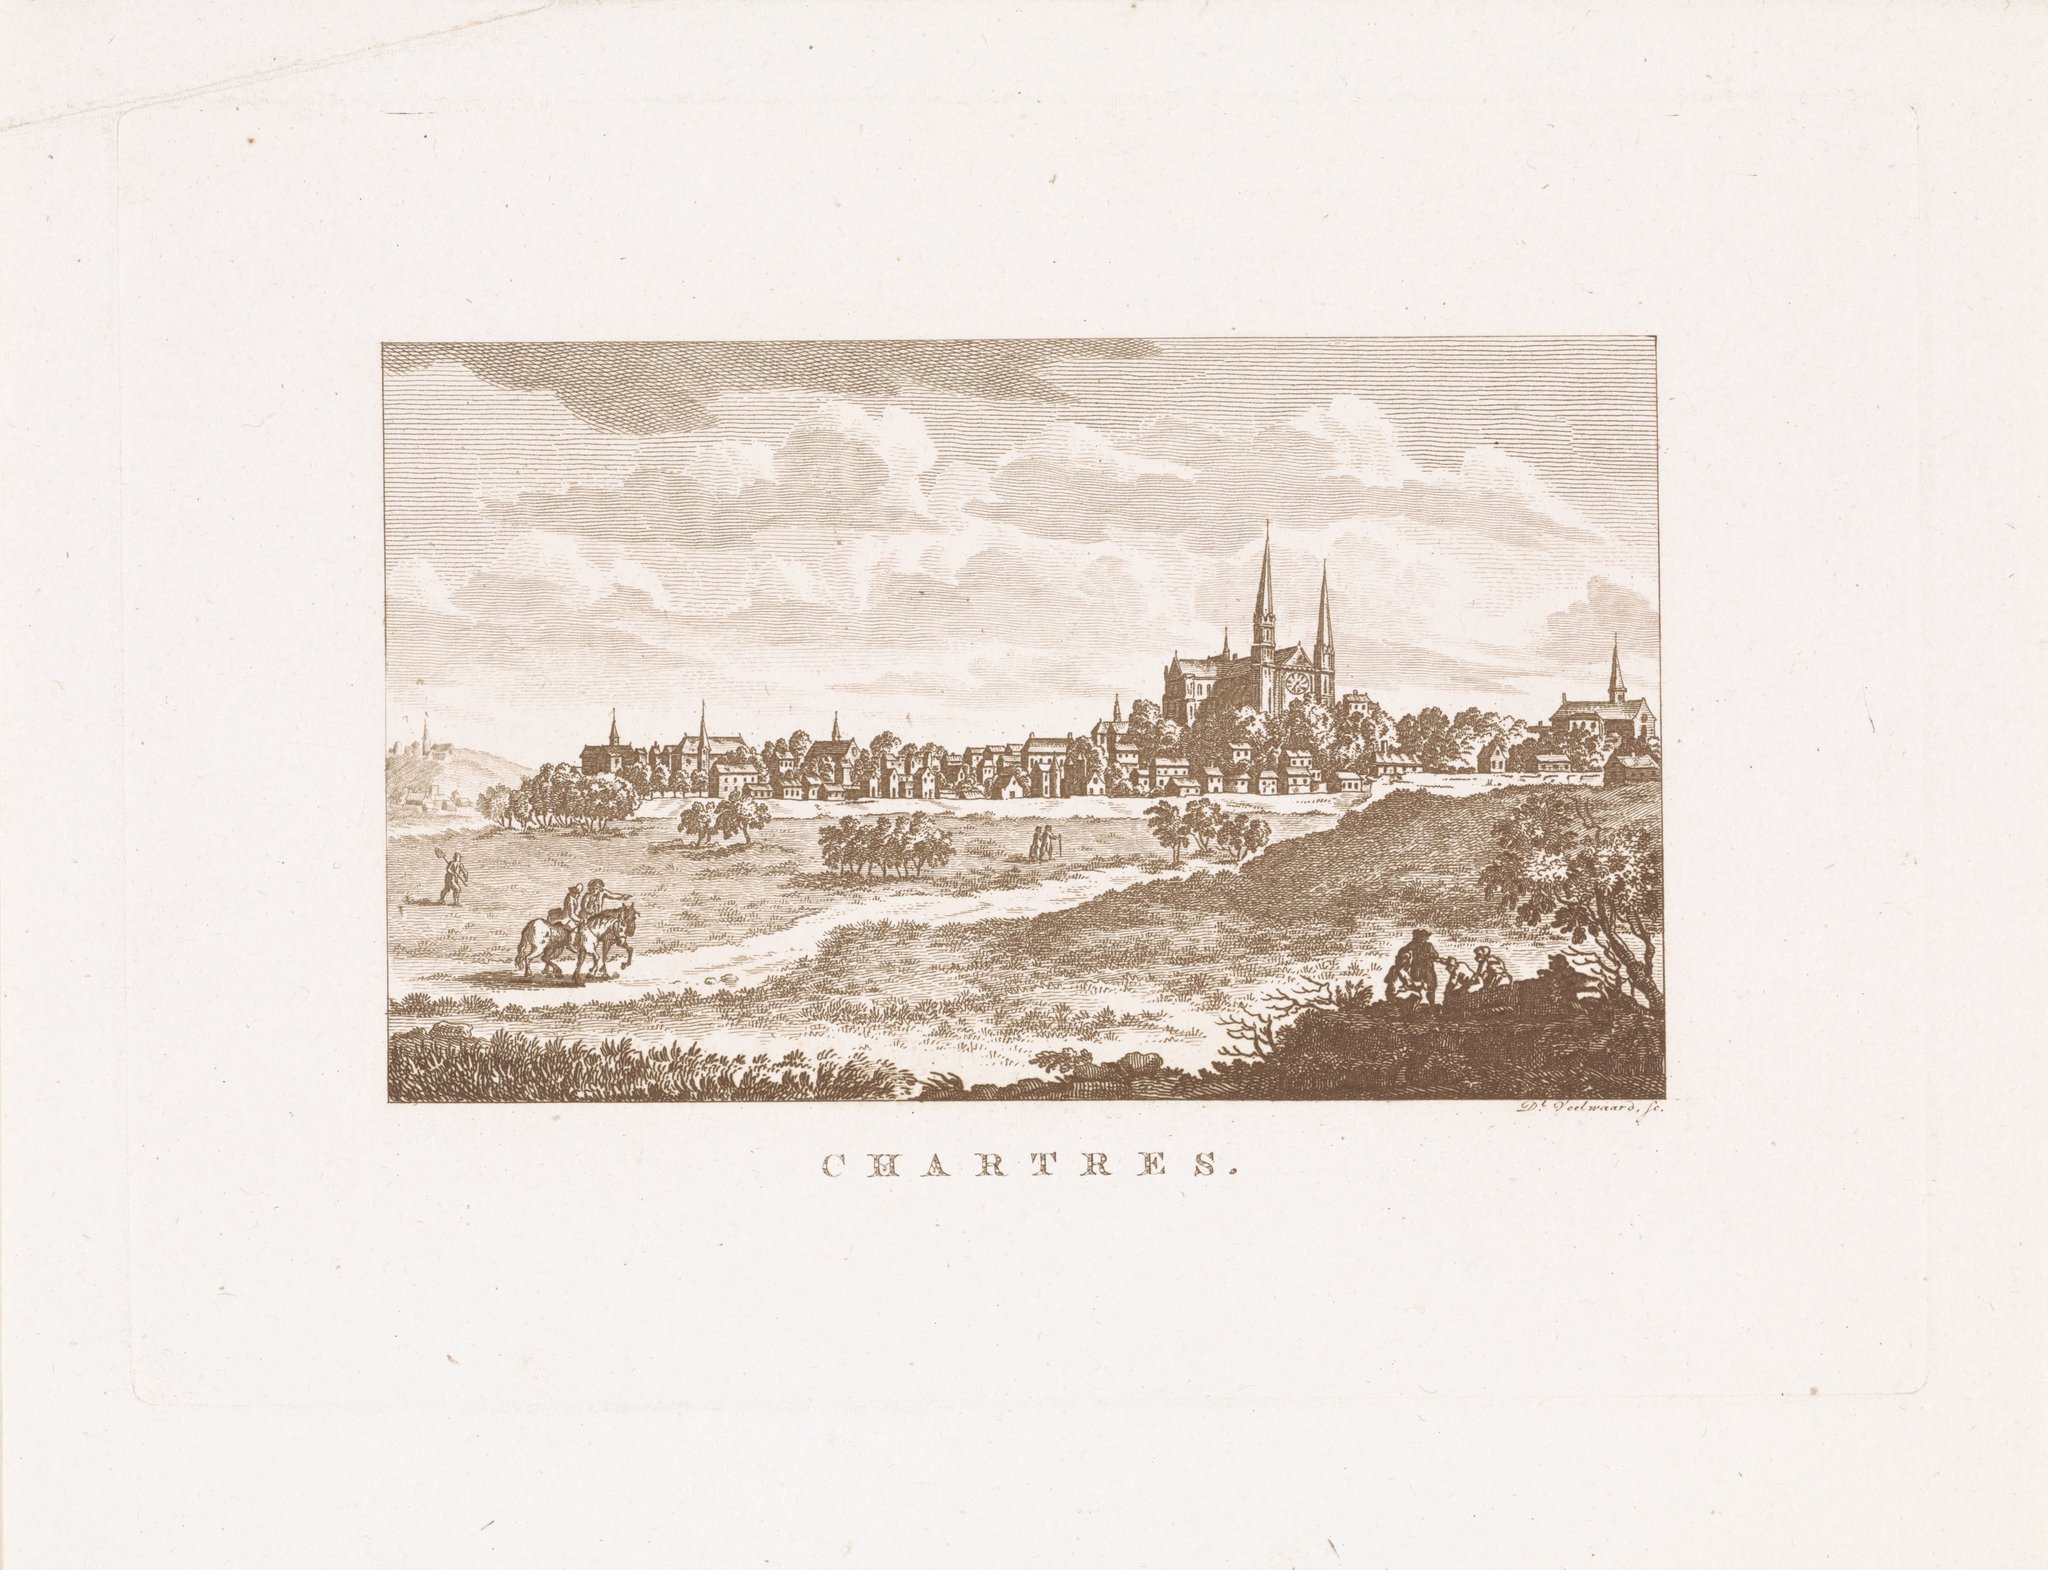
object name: print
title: Chartres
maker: daniël veelwaard (i)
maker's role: print maker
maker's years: 1766-1851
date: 1776-1851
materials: paper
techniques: etching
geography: amsterdam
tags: prospect of city, town panorama, silhouette of city (+ city(-scape) with figures, staffage)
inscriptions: collector's mark: Lugt 2228